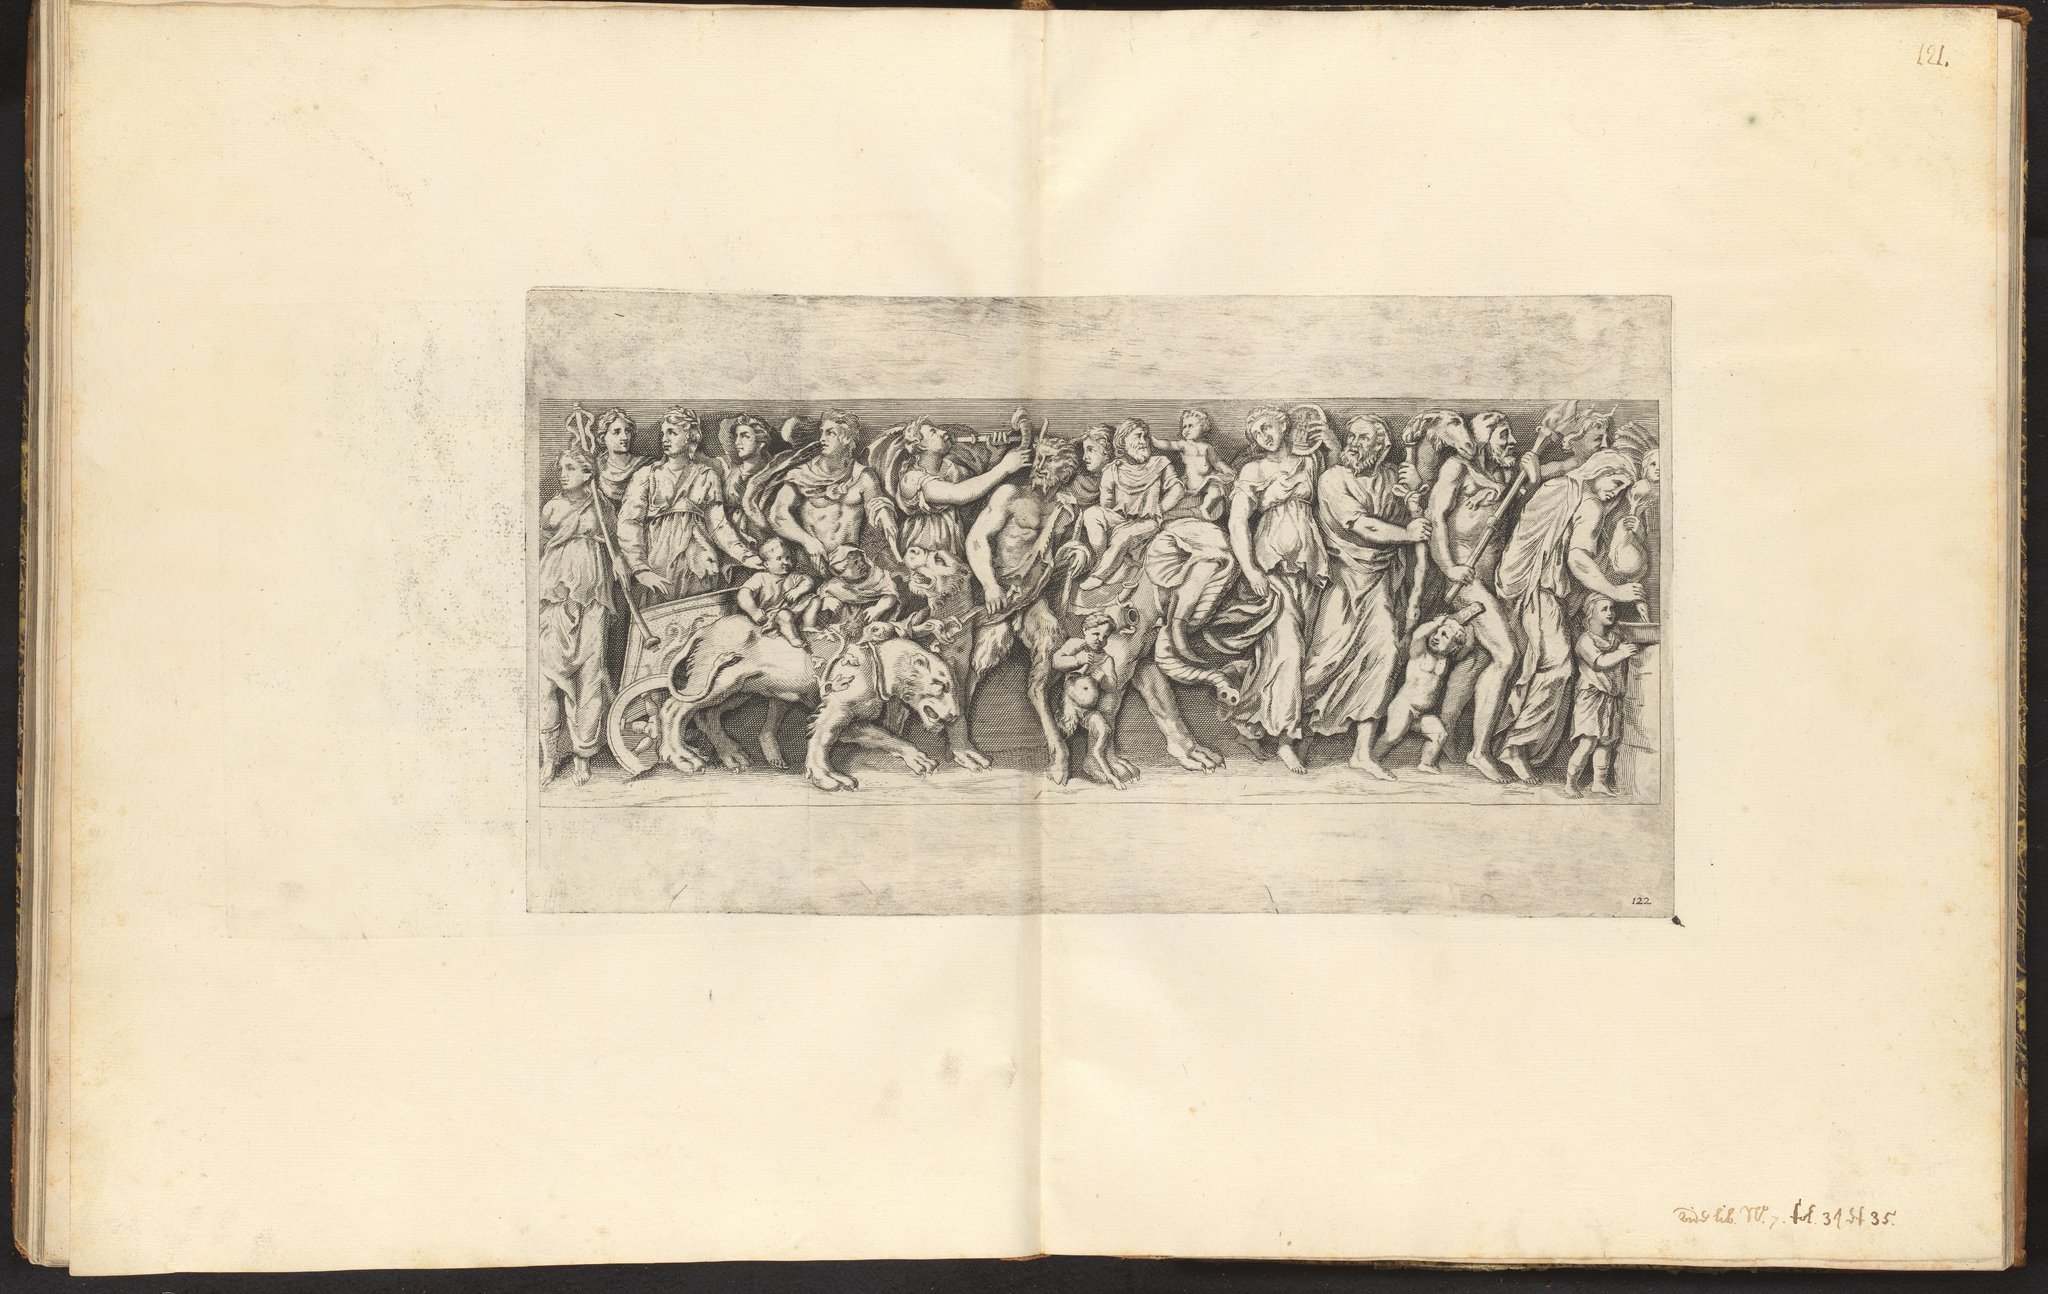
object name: print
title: Bas-reliëf met de triomf van Bacchus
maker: gabriel ladame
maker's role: print maker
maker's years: 1613-1679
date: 1636-1647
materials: paper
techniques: engraving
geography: rome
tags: triumph of bacchus; 'carro di bacco' (ripa), piece of sculpture, reproduction of a piece of sculpture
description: Bas-reliëf. Bacchus rijdt in zijn triomfwagen getrokken door tijgers. In de stoet verschillende figuren. Prent maakt deel uit van een album met een serie prenten naar de sculpturen in de verzameling in de Galleria Giustiniani te Rome.